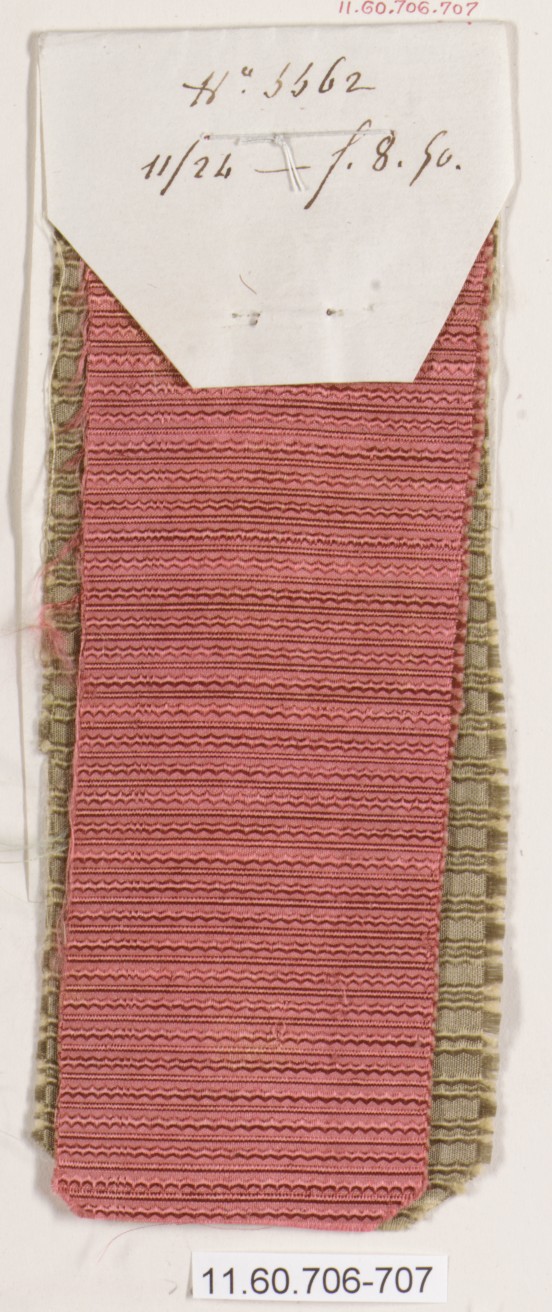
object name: sample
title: Samples (2)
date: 1801-1850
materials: silk